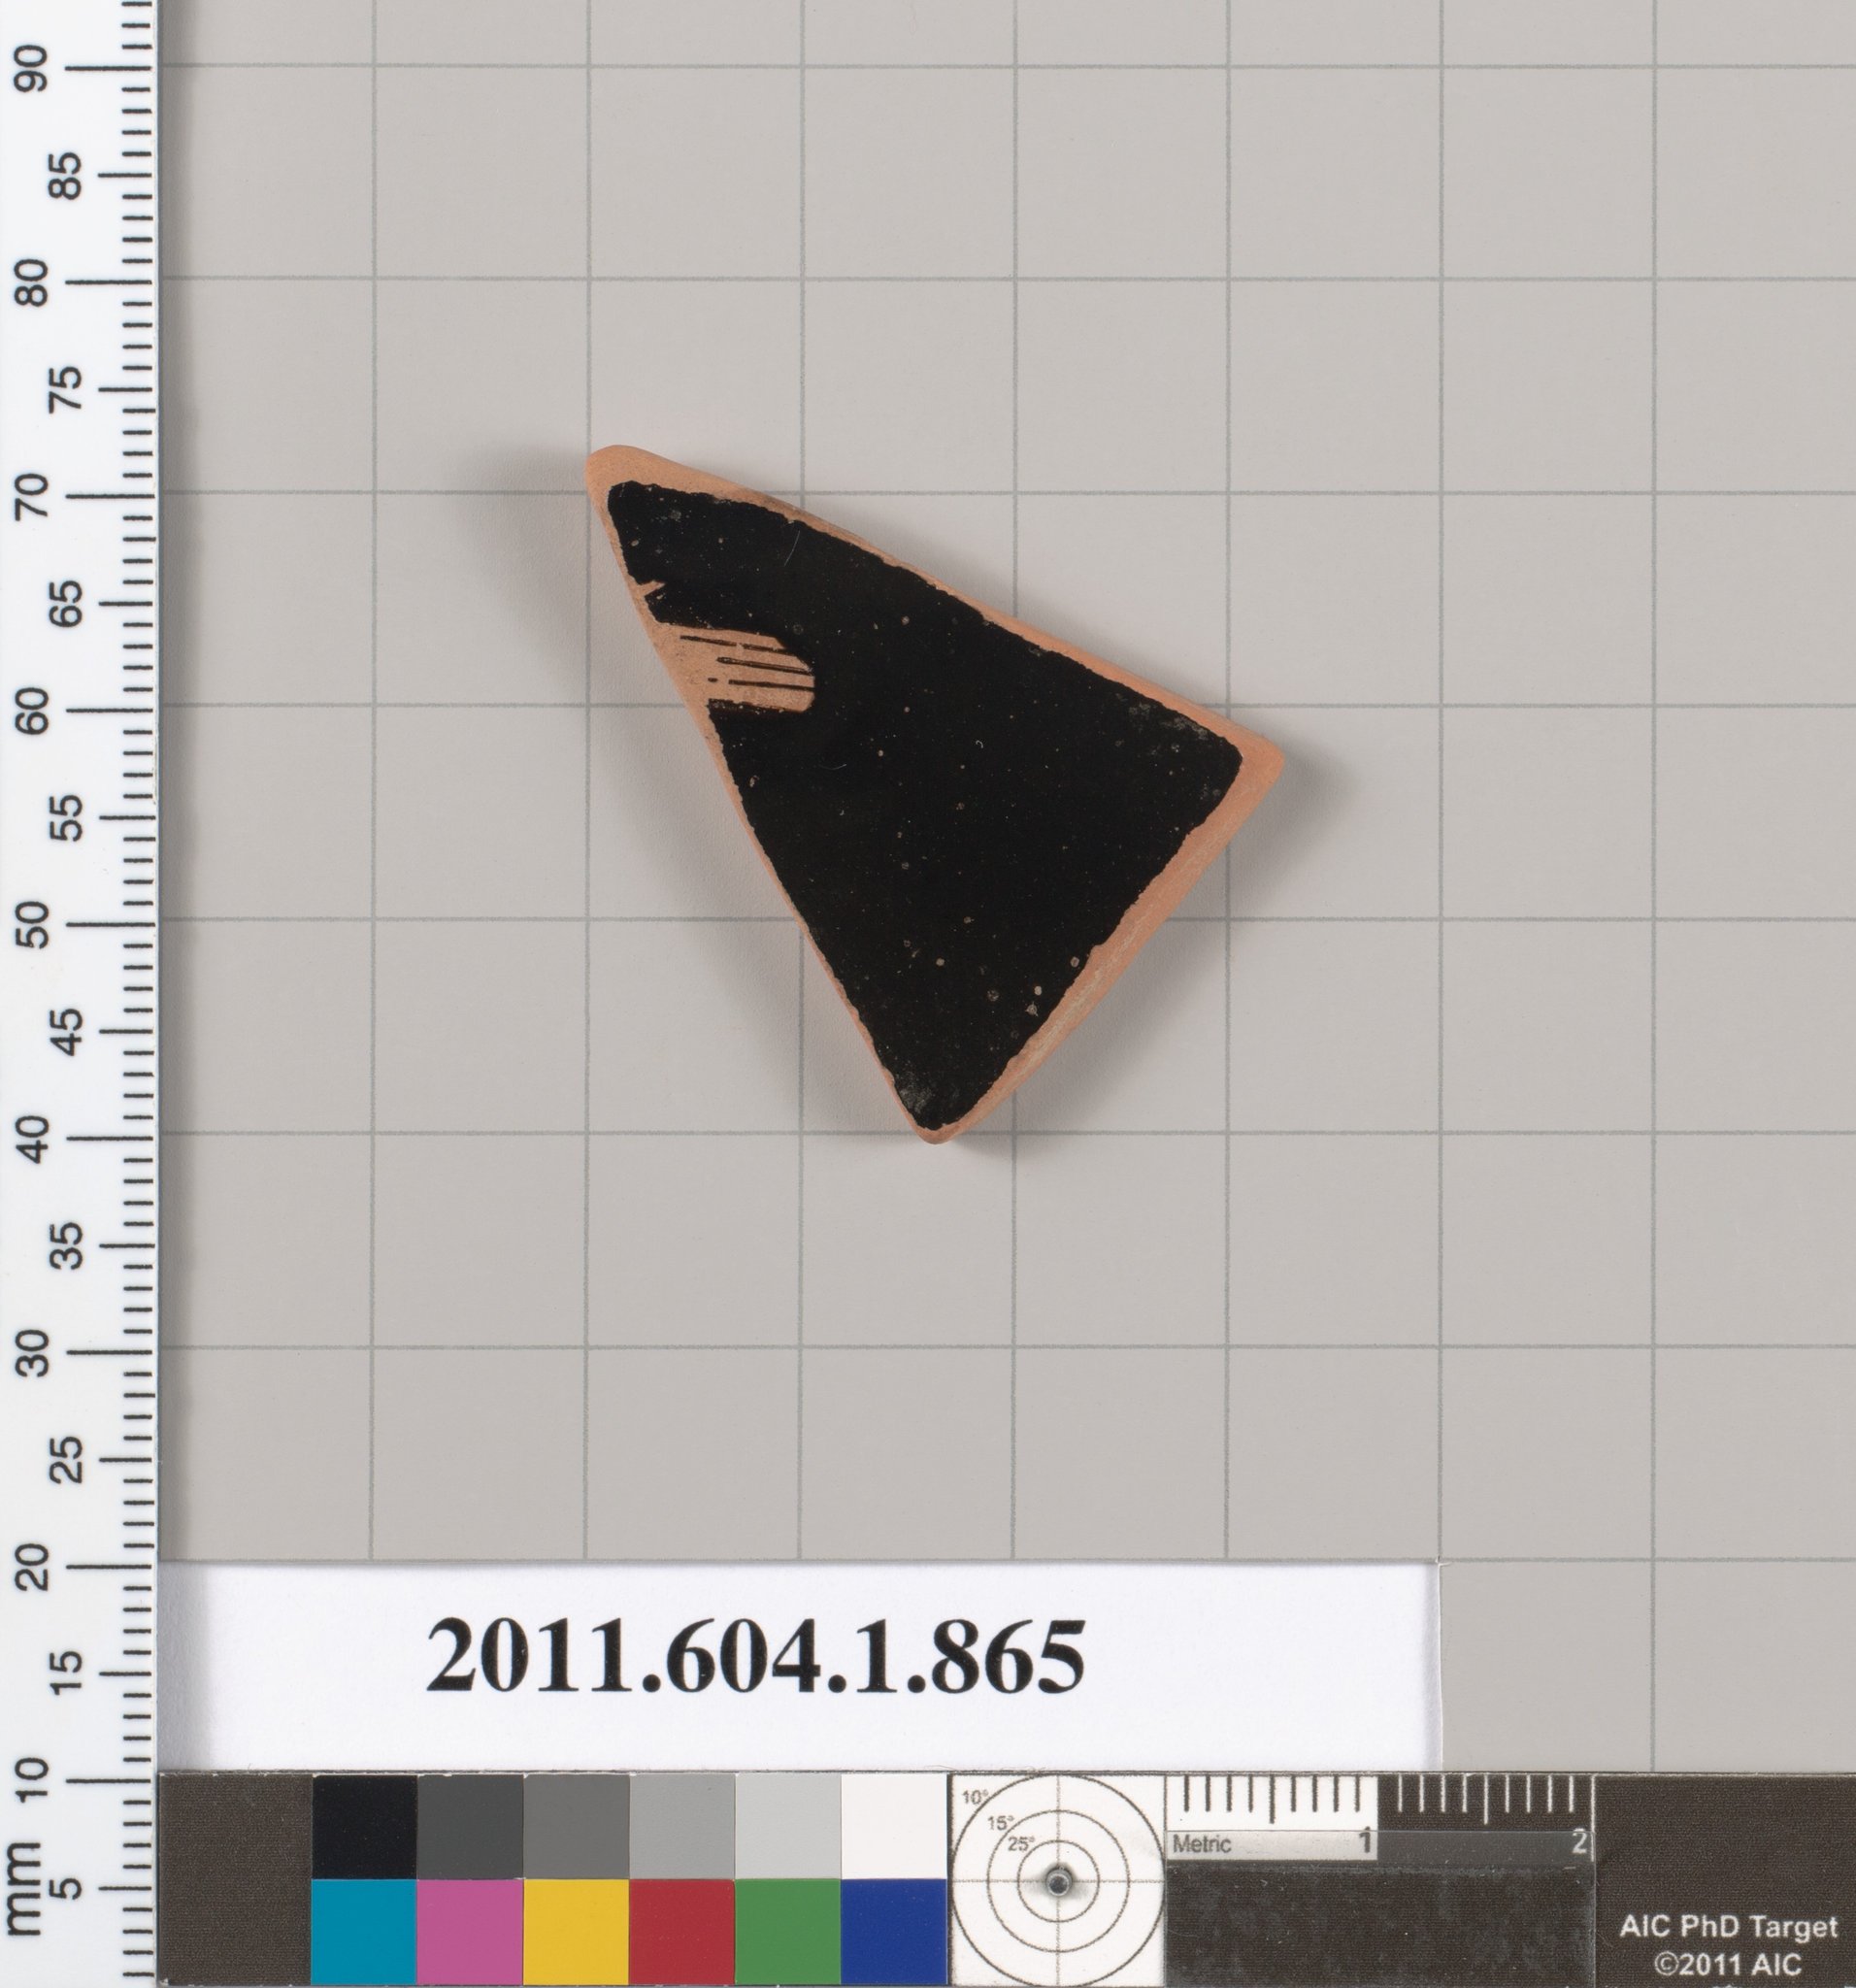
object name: kylix fragment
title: Terracotta fragment of a kylix (drinking cup)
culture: greek, attic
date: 500-451 BCE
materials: terracotta